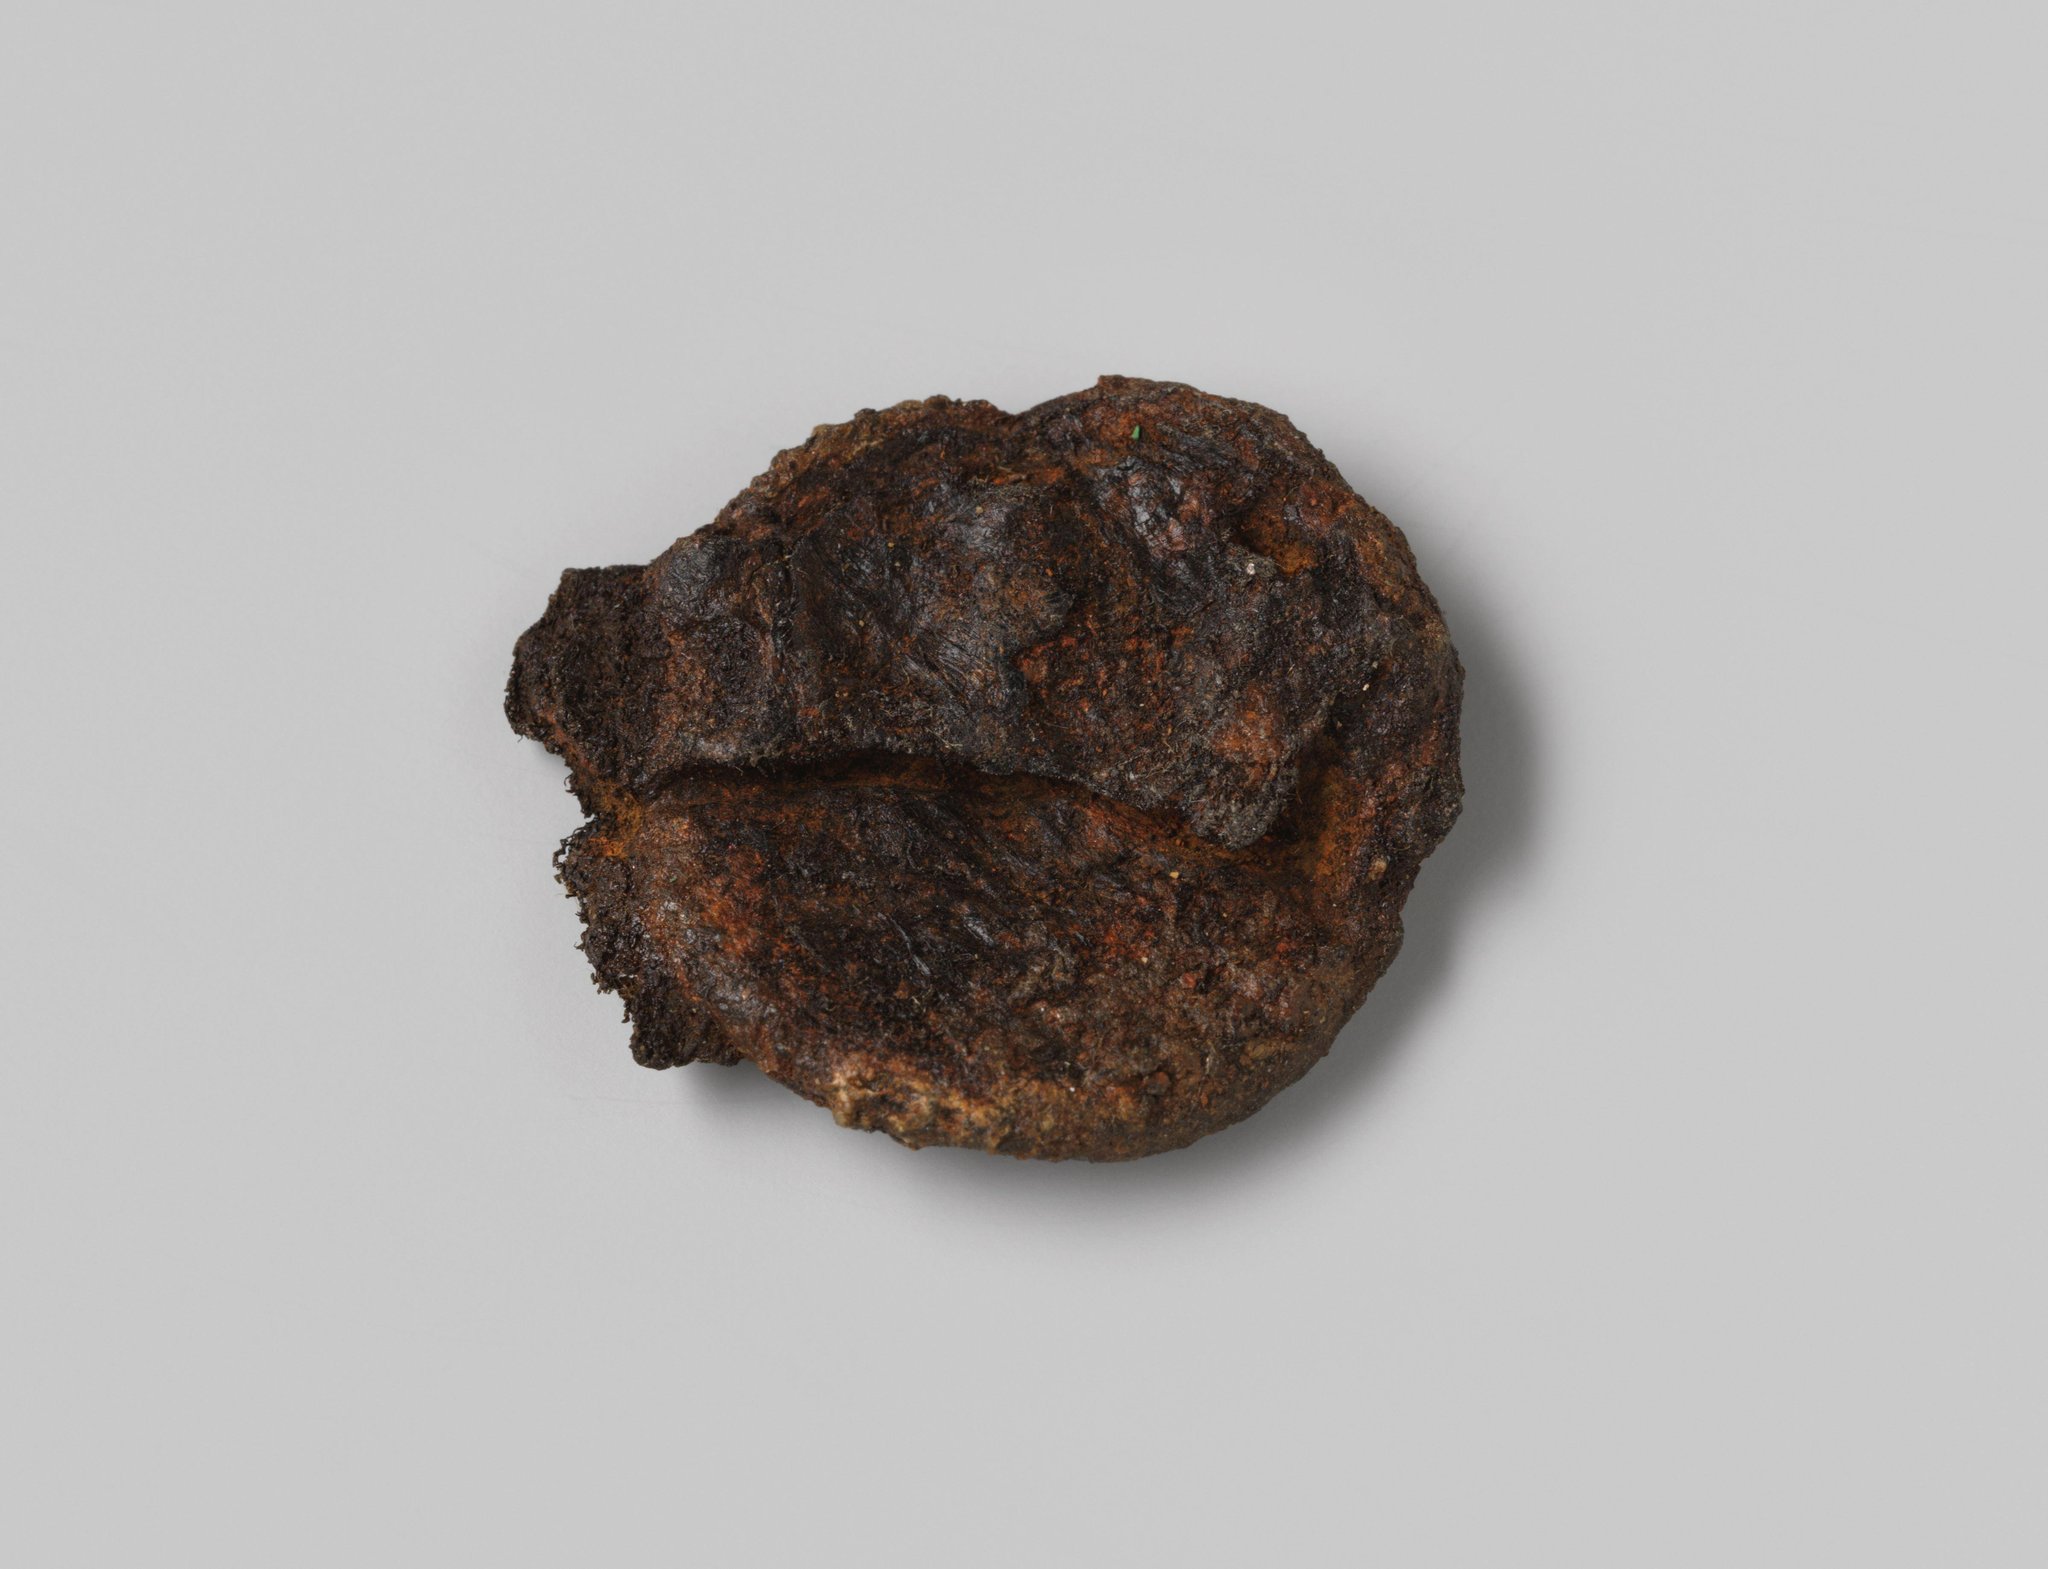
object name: fragment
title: Fragment uit het wrak van de Oost-Indiëvaarder Hollandia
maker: Anonymous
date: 1700-1743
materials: leather, metal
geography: netherlands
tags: verenigde oostindische compagnie, hollandia (schip), annet